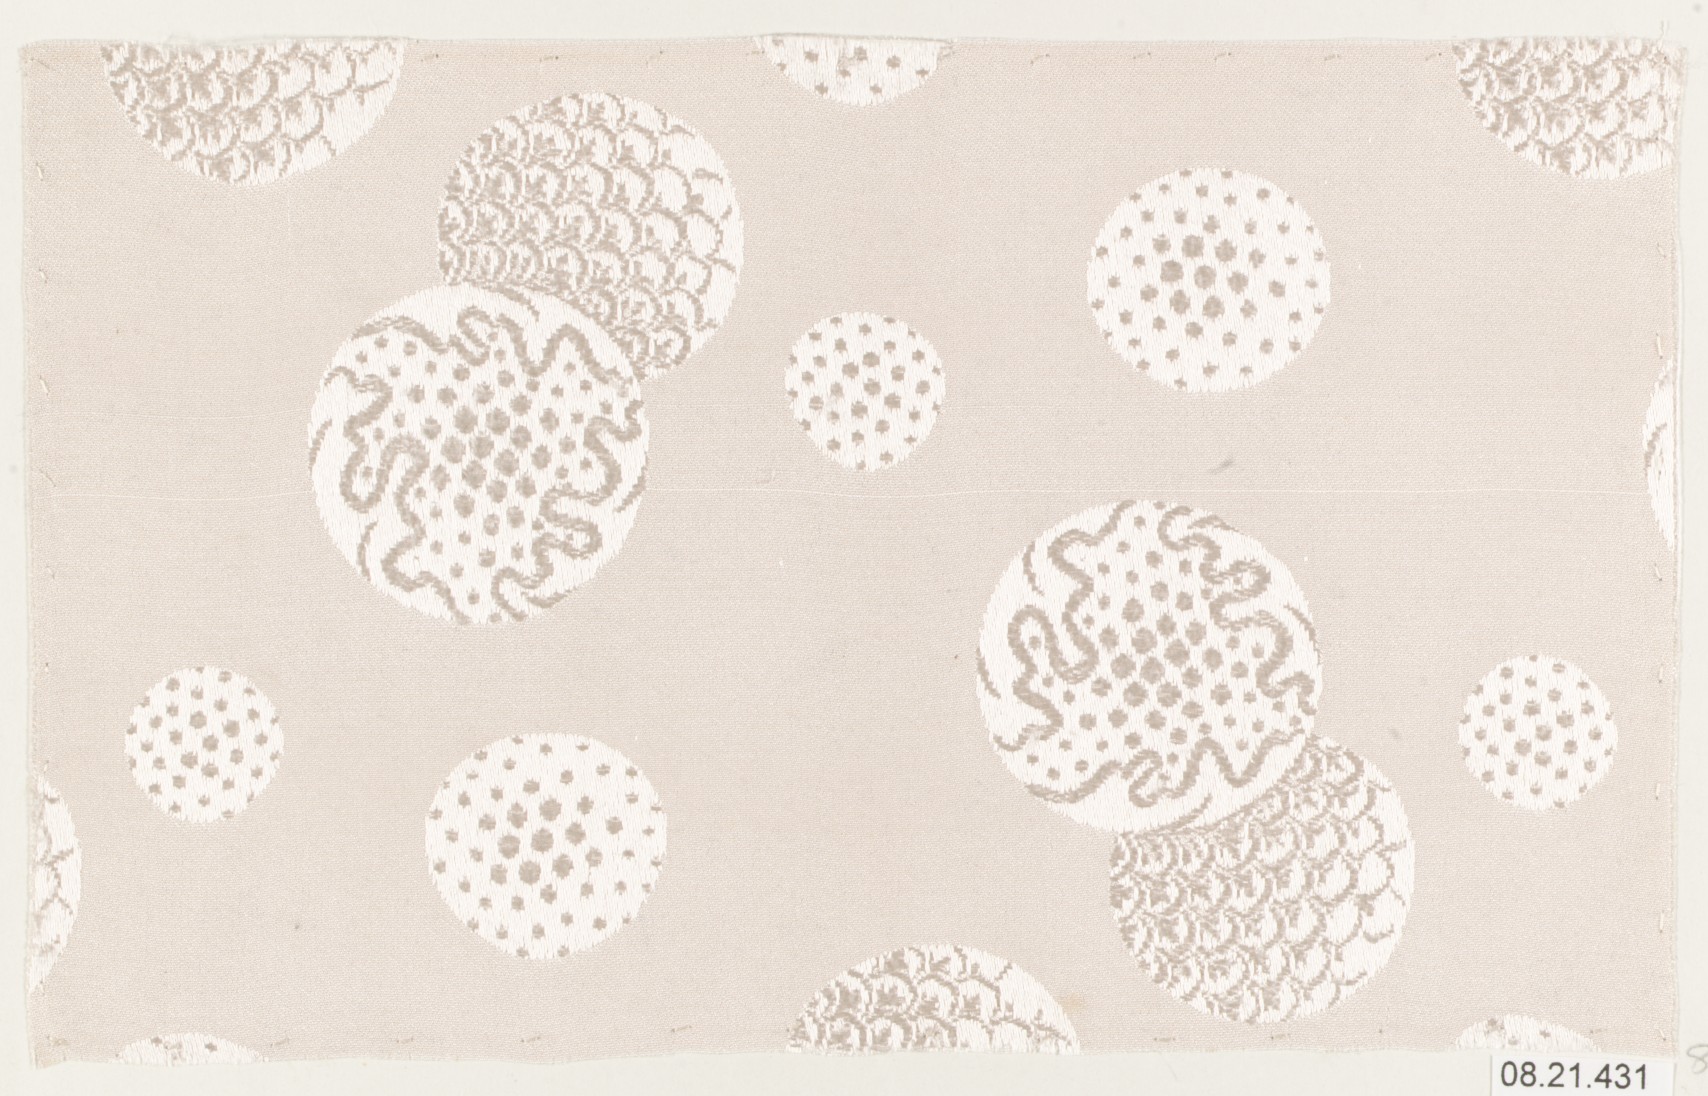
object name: textile sample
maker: Anonymous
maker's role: designer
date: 1900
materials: silk